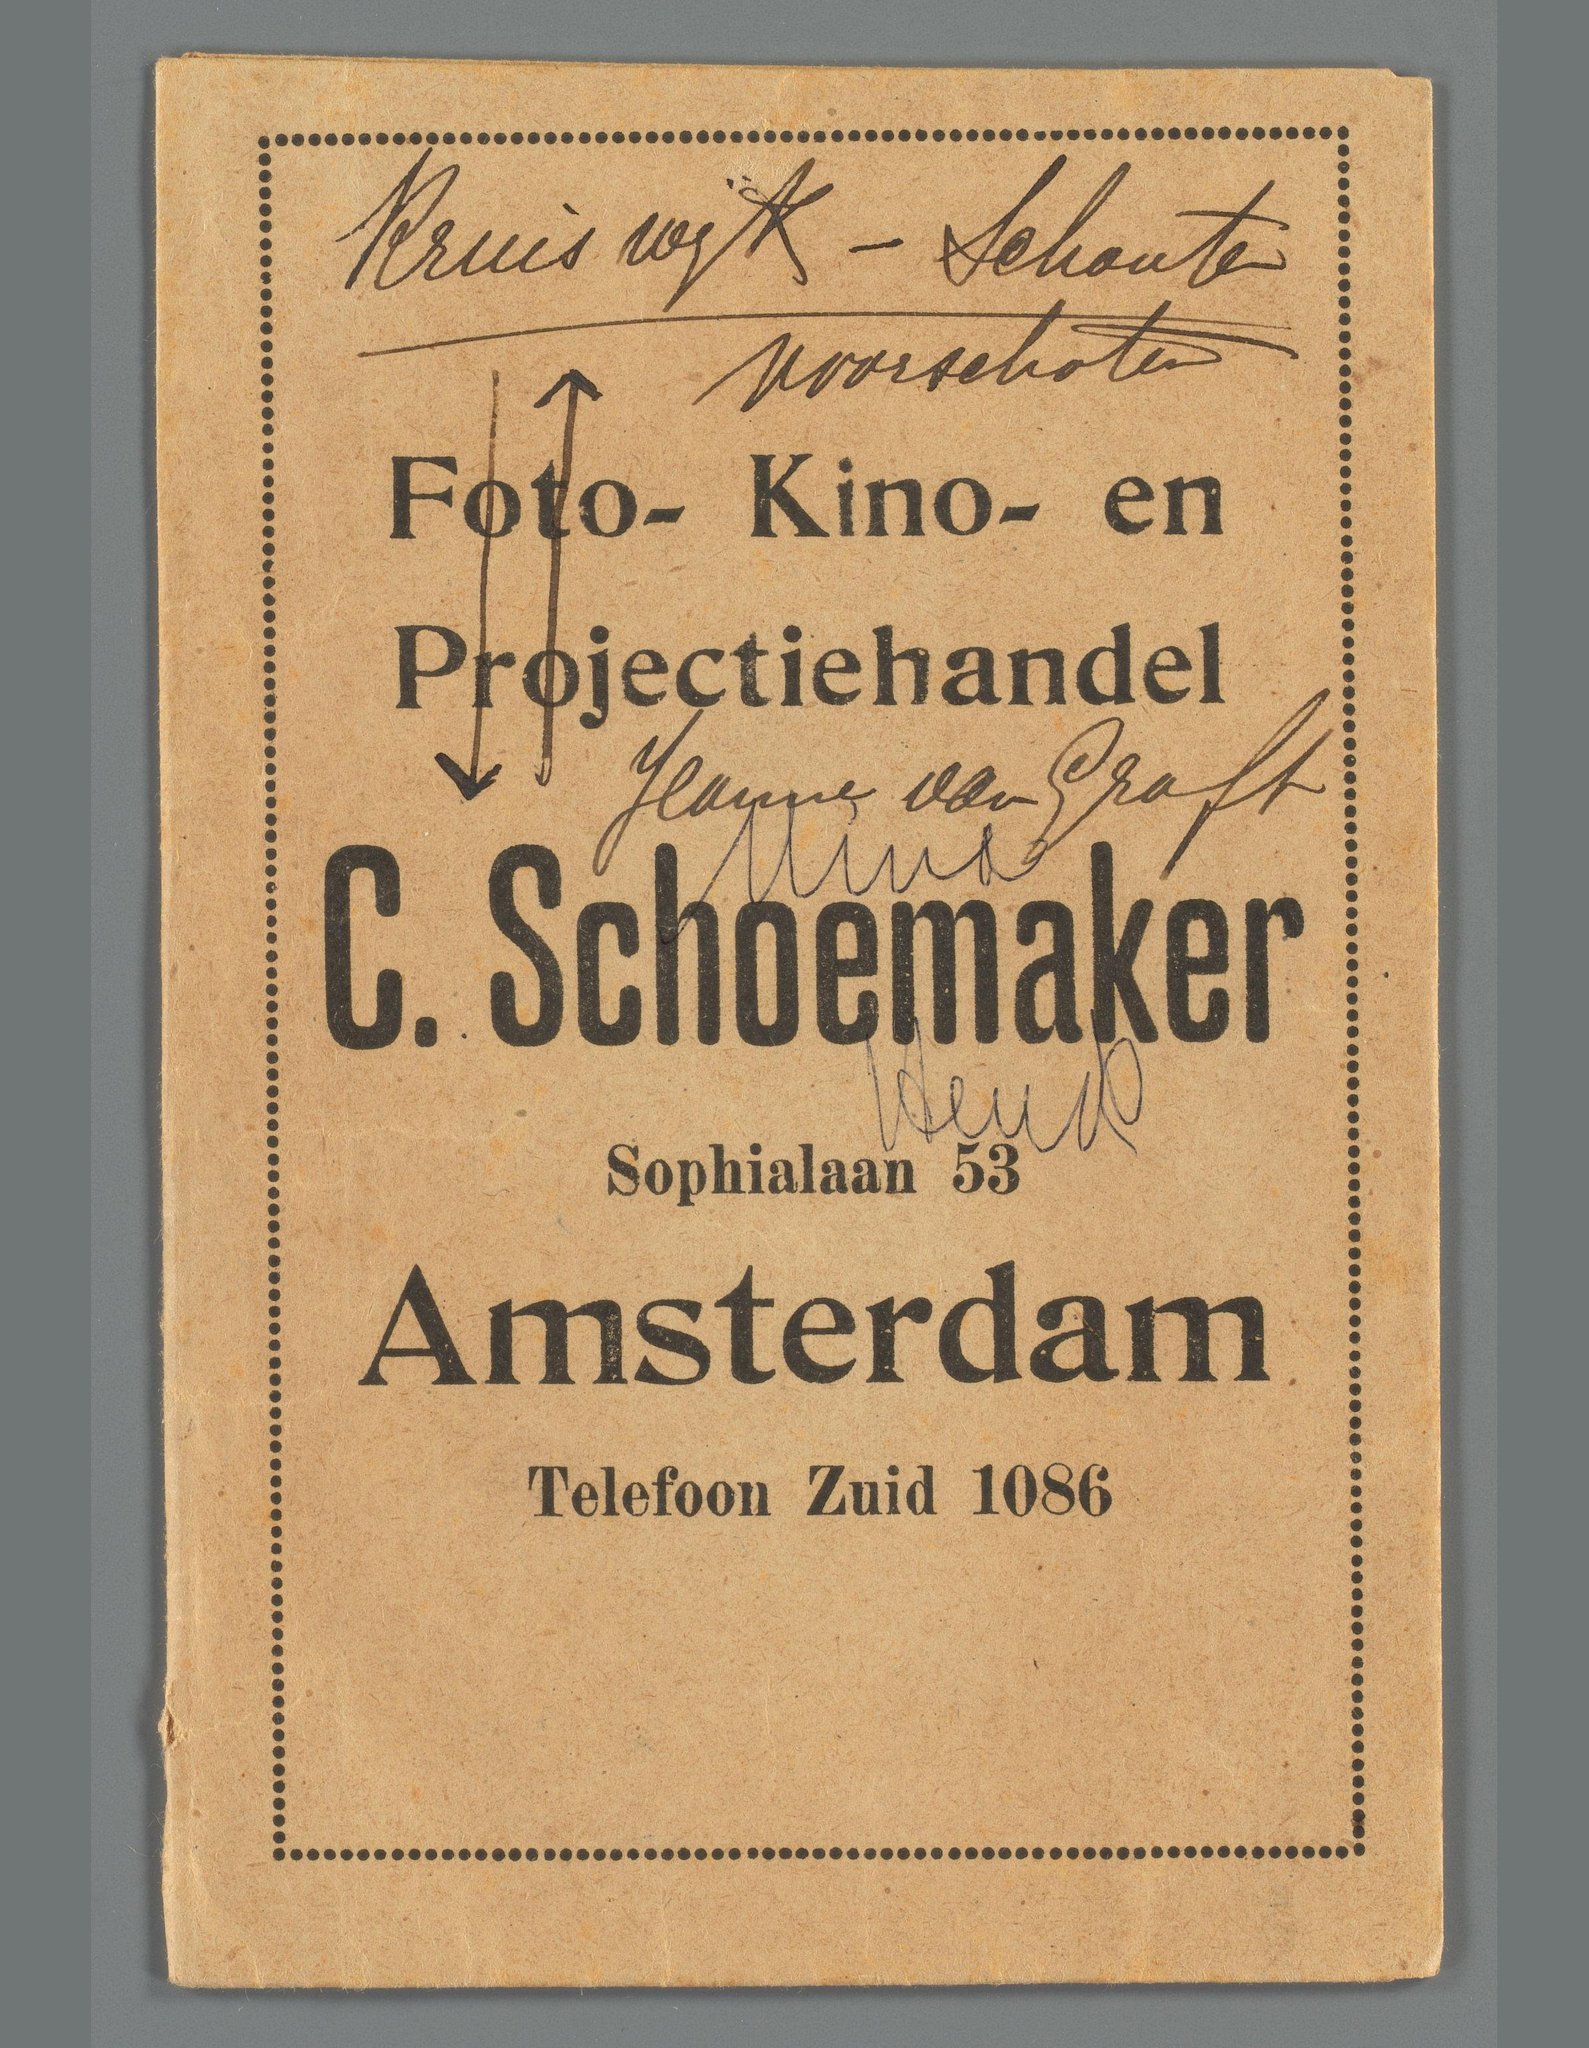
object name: photomap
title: Foto- Kino- en Projectiehandel C. Schoemaker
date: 1920-1940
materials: paper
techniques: letterpress printing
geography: amsterdam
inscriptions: inscription: ‘Kruiswijk - Schouten/ Voorschoten/ Jeanne van Graft [...]’